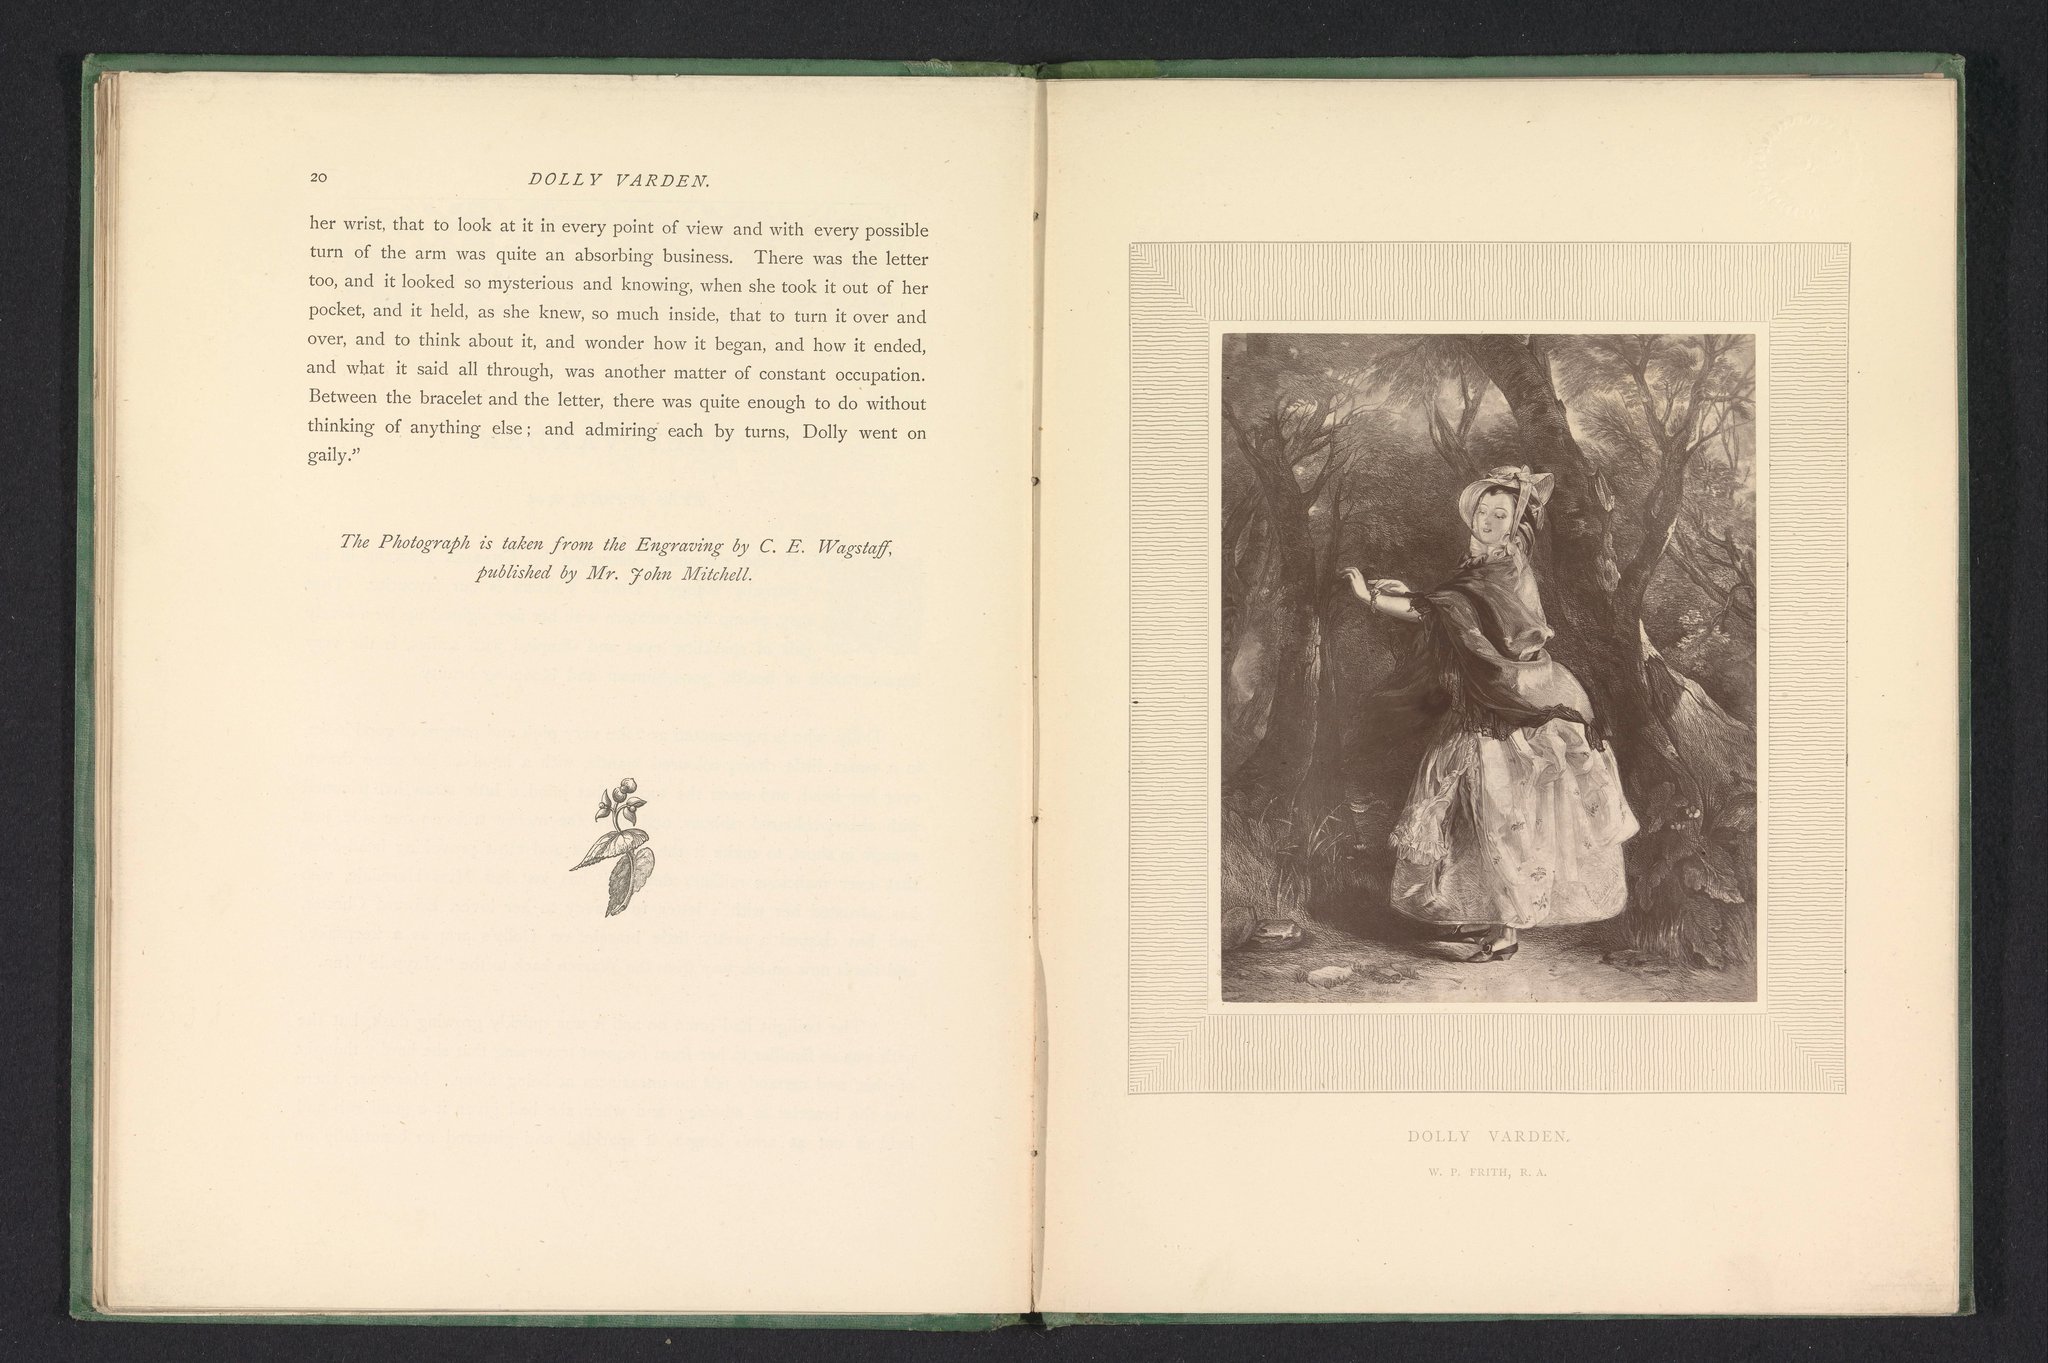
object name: reproduction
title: Dolly Varden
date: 1863-1873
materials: paper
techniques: woodburytype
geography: london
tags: picture, painting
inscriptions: name: ‘[...] 18[...]’